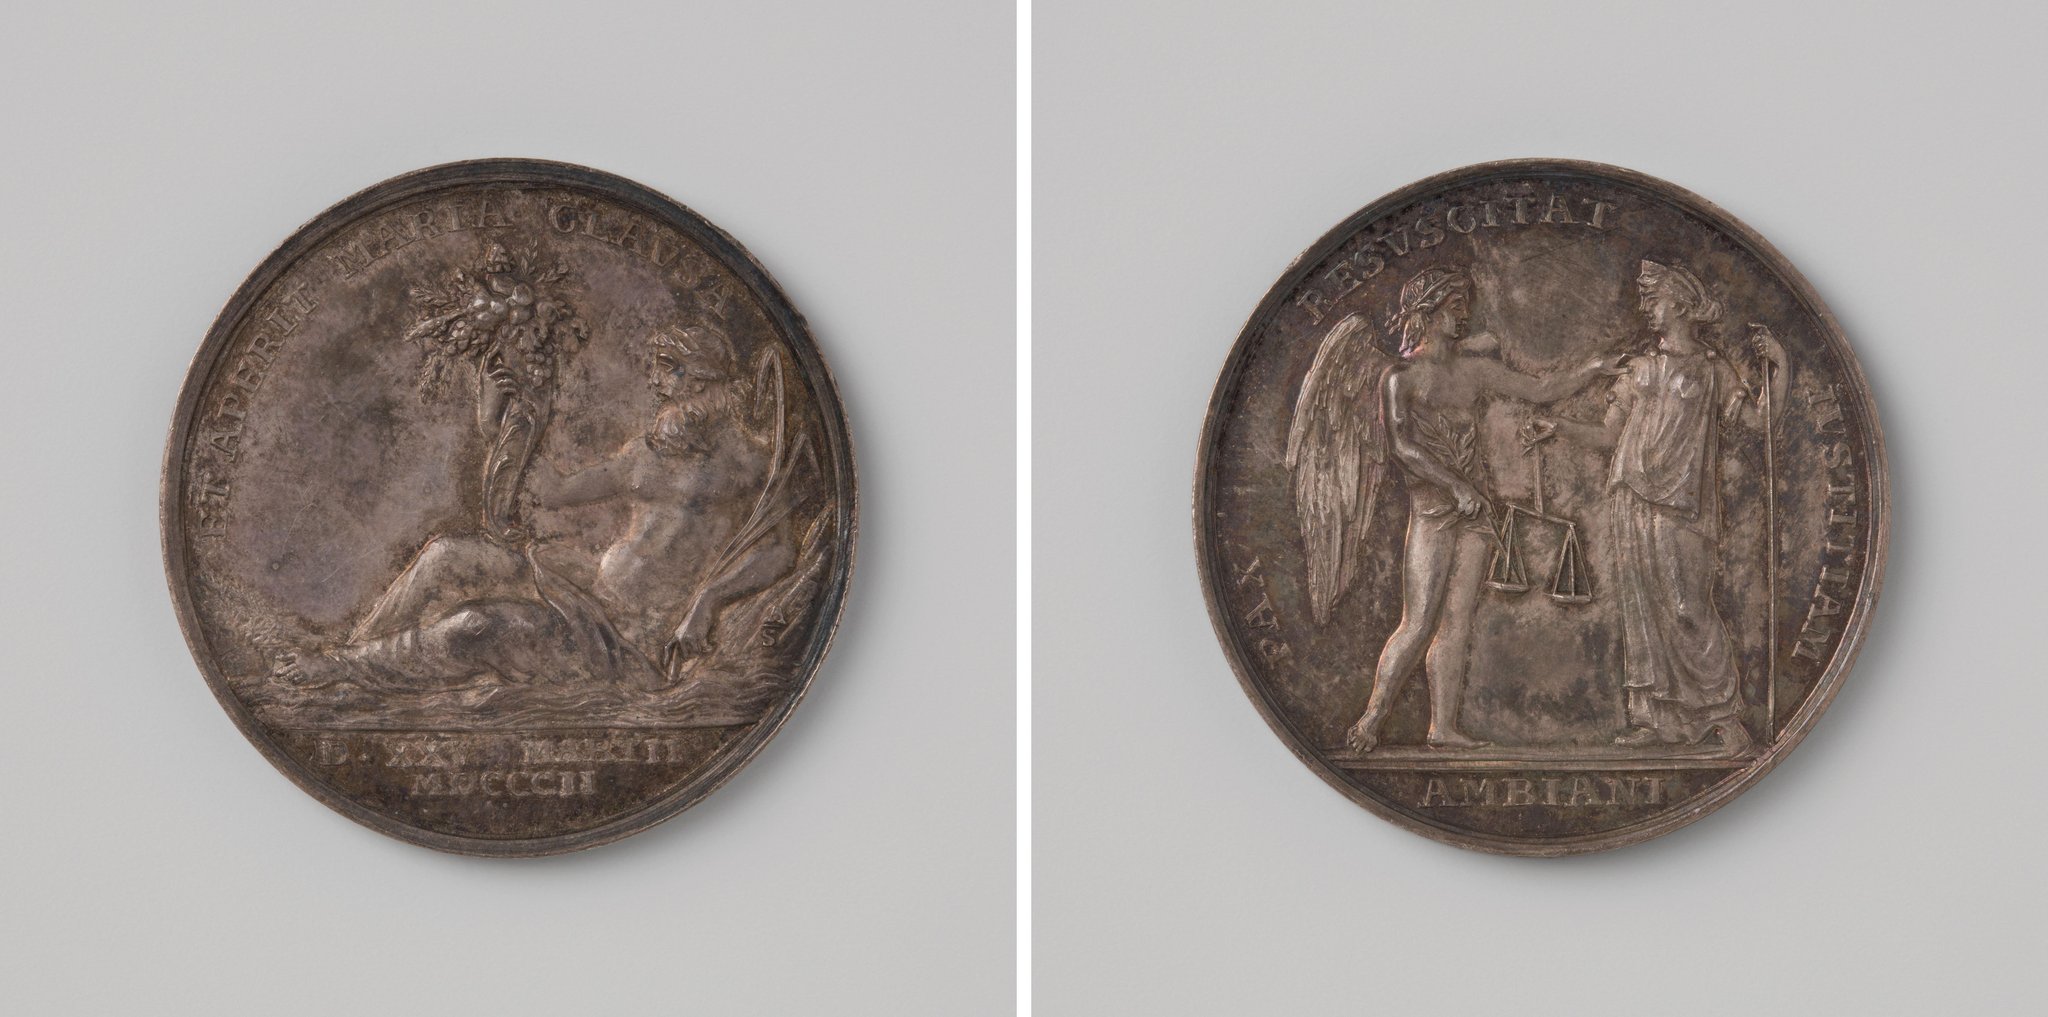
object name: history medal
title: Vrede van Luneville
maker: daniel friedrich loos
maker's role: medailleur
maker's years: 1735-1819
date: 1801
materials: silver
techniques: striking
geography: berlin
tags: lunéville, tweede coalitie-oorlog, franse revolutie, vrede van lunéville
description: Zilveren penning. Voorzijde: vrede met olijftak en gevulde hoorn van overvloed staande op wereldbol temidden van optrekkende wolken binnen omschrift. Keerzijde: Minerva houdt Medusa-schild voor aan Bellona, die toorts in haar linkerhand houdt en zwaard van schrik uit rechterhand laat vallen binnen omschrift; afsnede: datering